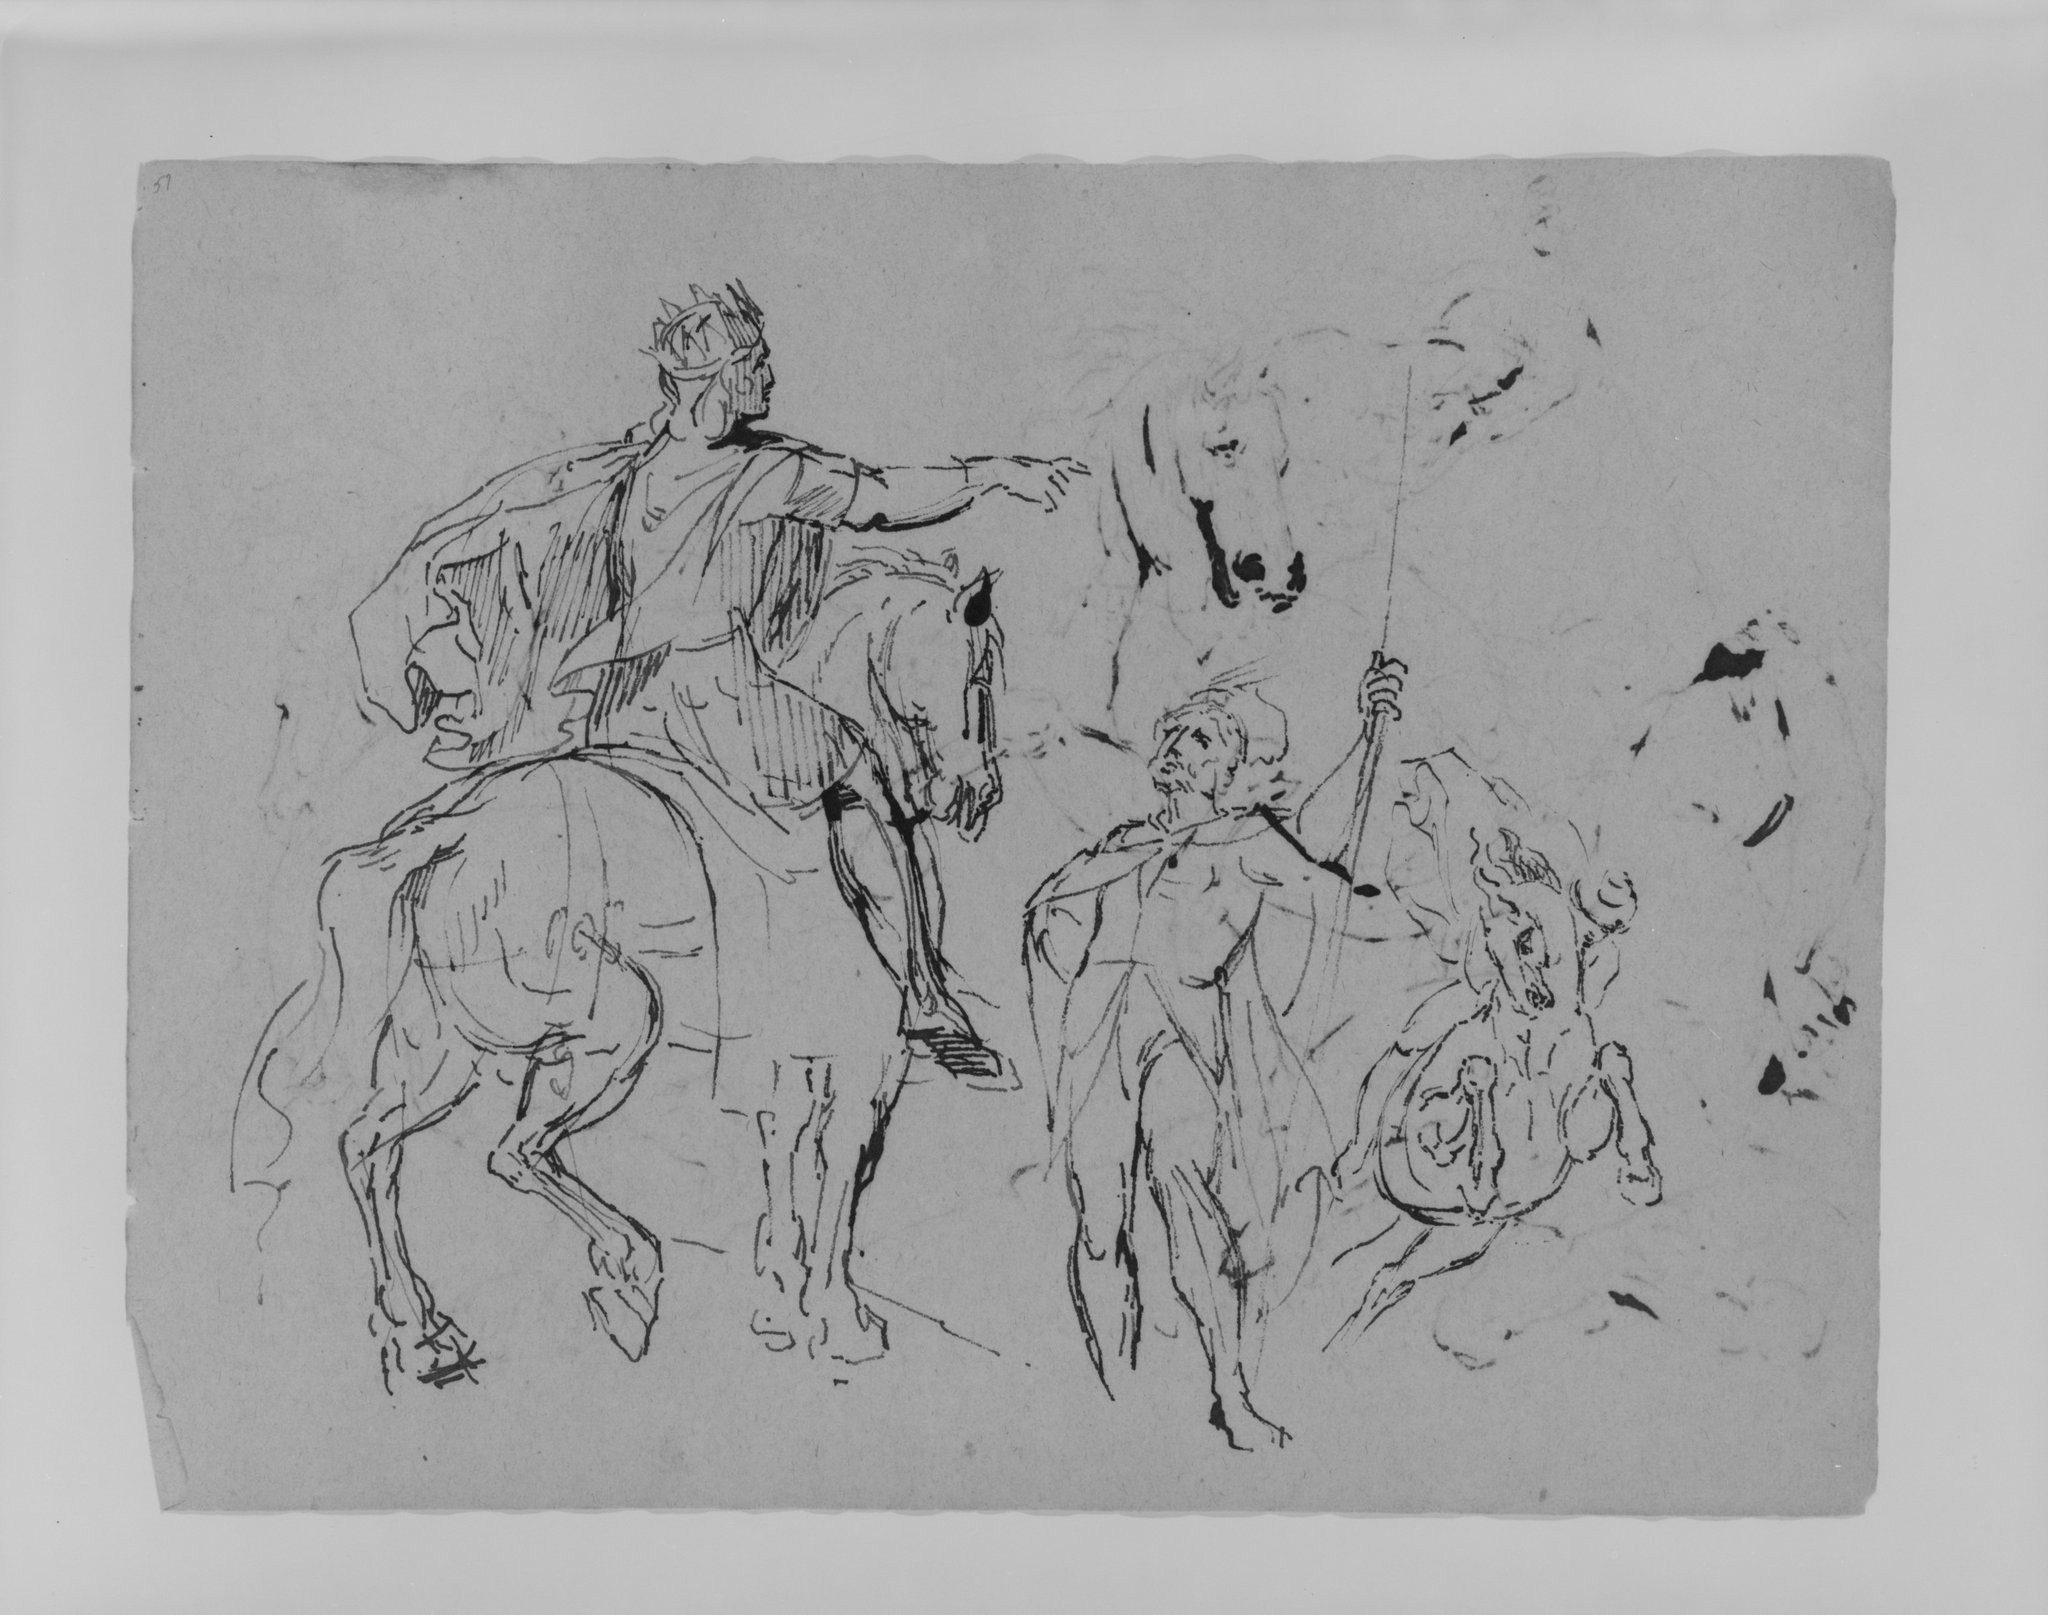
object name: drawing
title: (From Sketchbook)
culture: american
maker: thomas sully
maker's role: artist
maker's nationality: american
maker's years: 1783-1872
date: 1810-1820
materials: ink, paper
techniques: wash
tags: men,horses